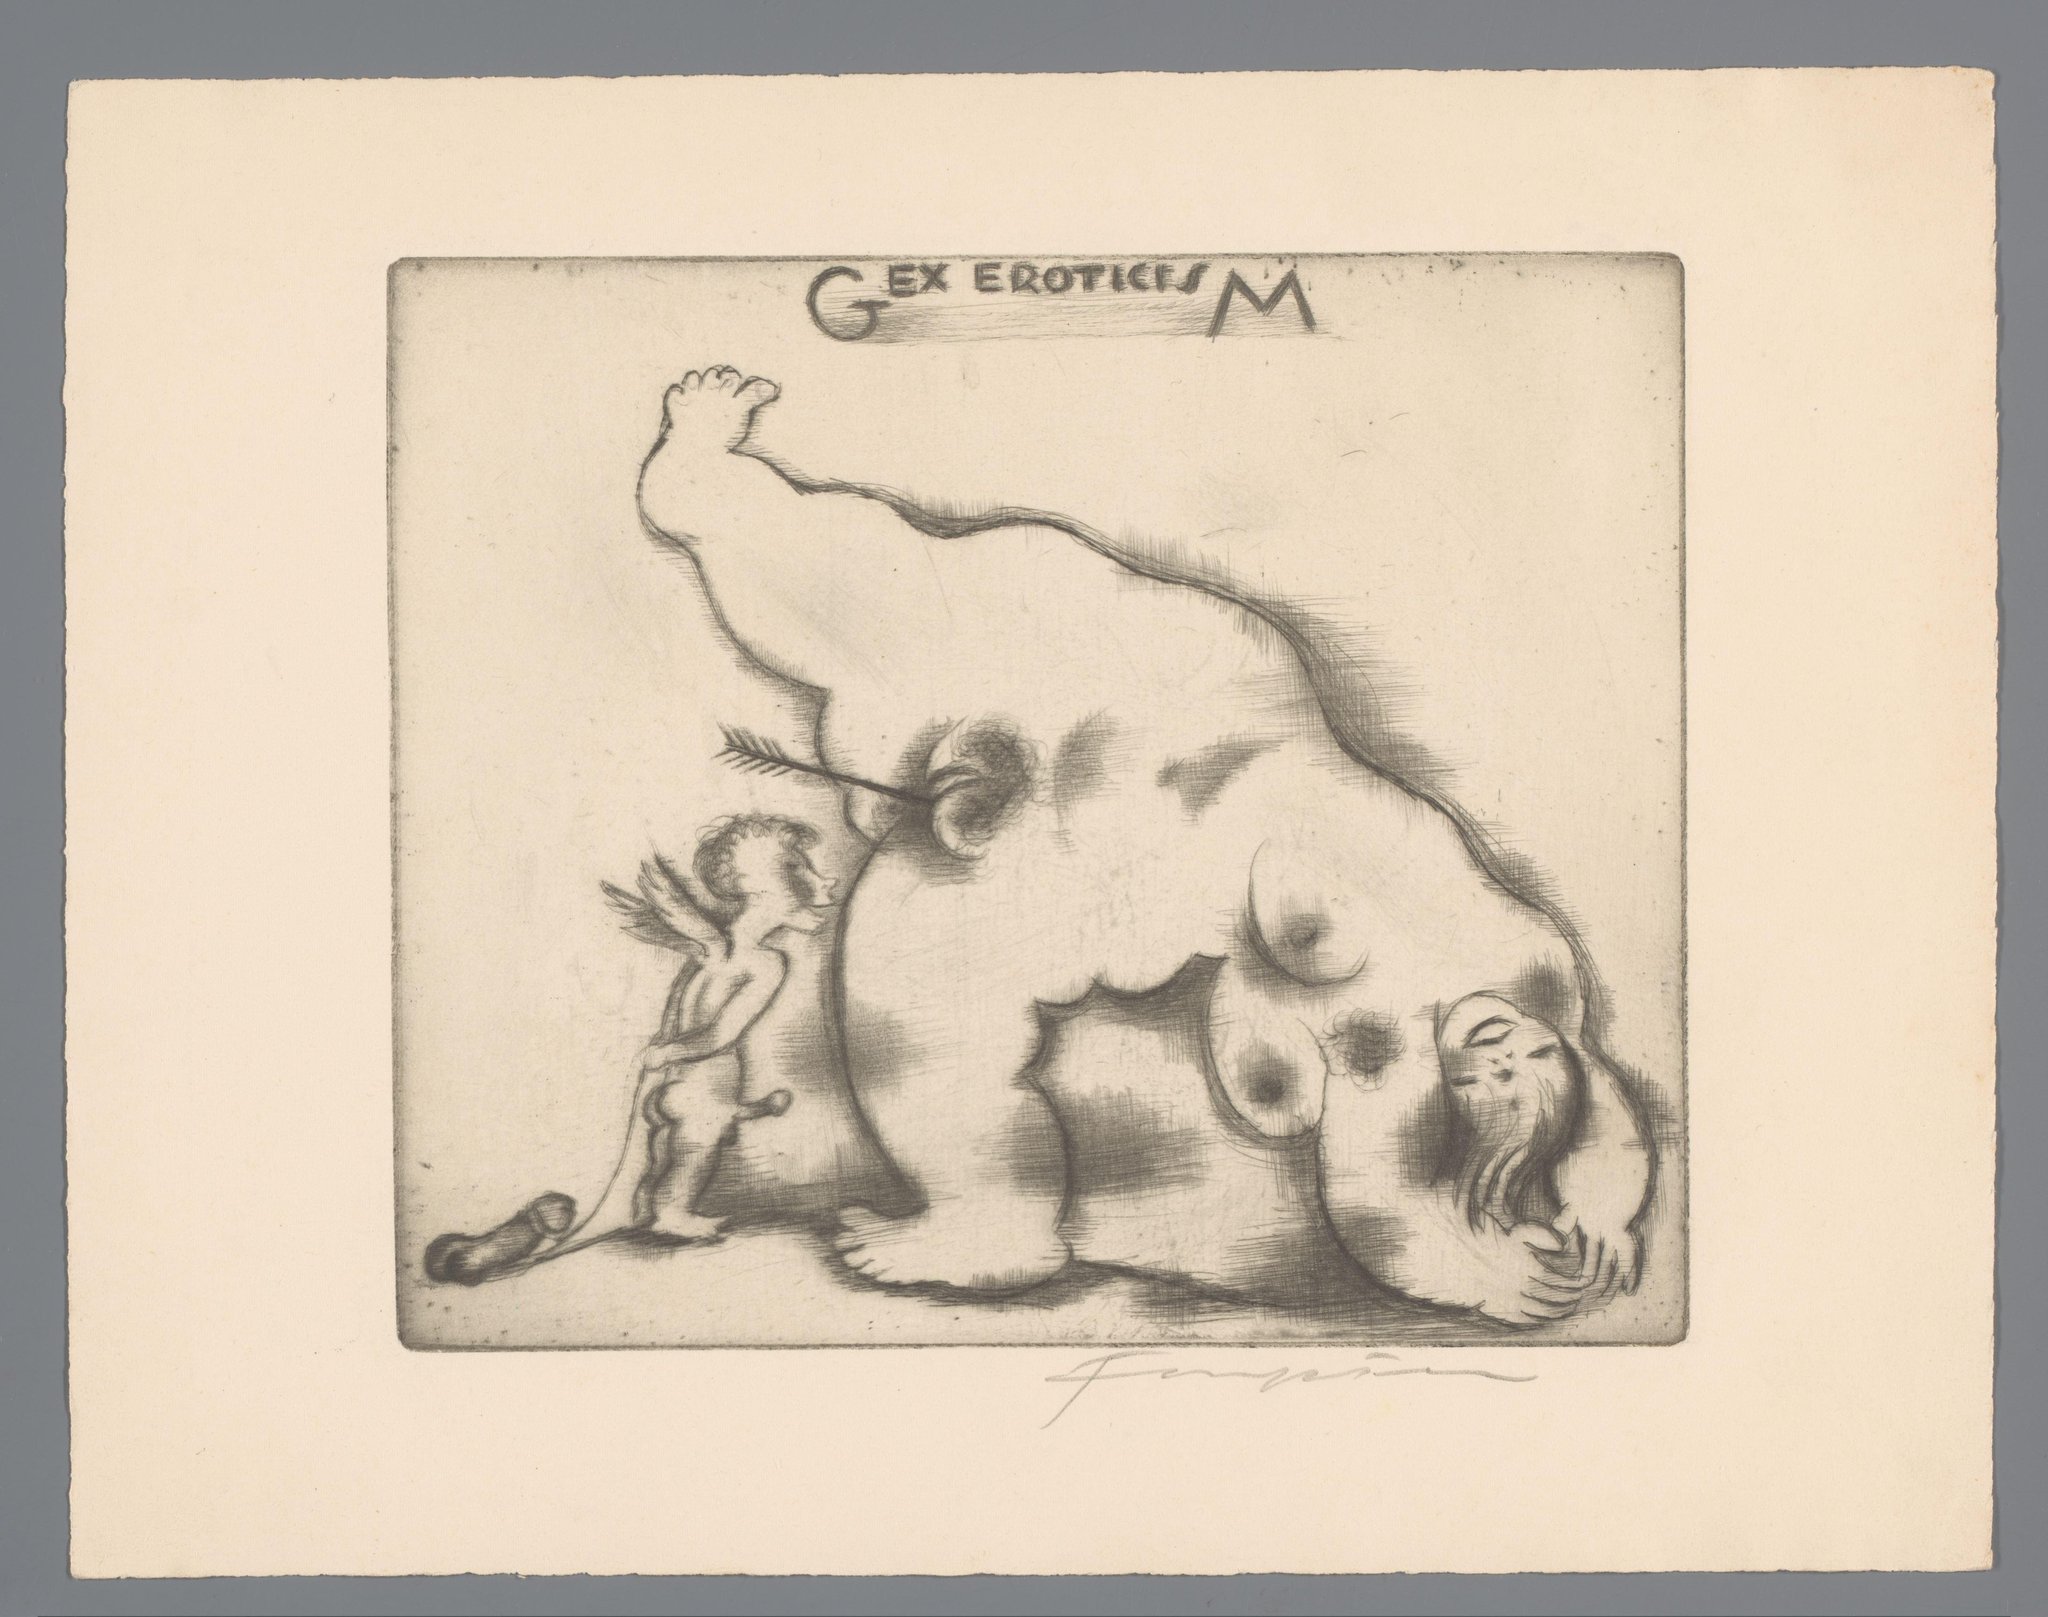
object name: bookplate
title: Gex eroticisM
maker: michel fingesten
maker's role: painter, print maker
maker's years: 1884-1943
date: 1907-1943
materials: paper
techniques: drypoint, intaglio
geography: milan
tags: engineer, gianni mantero, archer's weapons: arrow, woman (showing herself) undressed, quasi-nude, penis, phallus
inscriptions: workshop stamp: ‘Michel Fingesten/ Milano/ Punta secca originale/ Pointe seche originale/ Orig. Kalte Nädel-Rad.’, signature: ‘Fingesten’